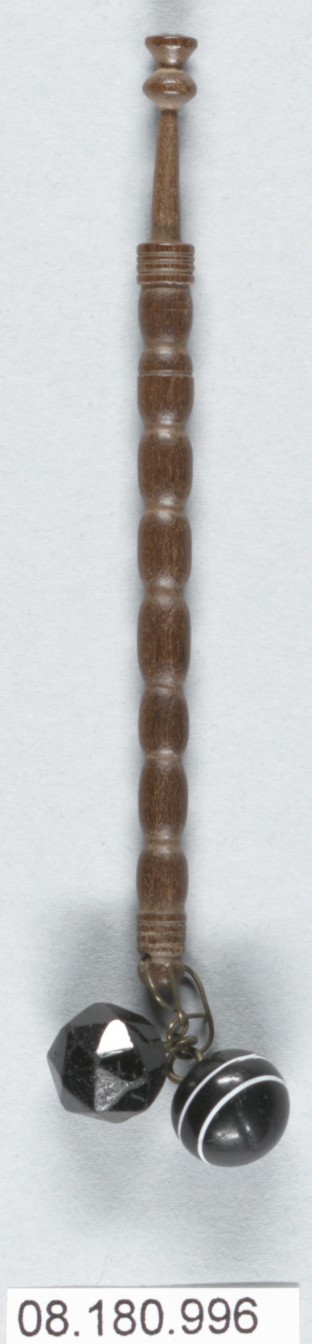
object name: bobbin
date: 1801-1900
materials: wood